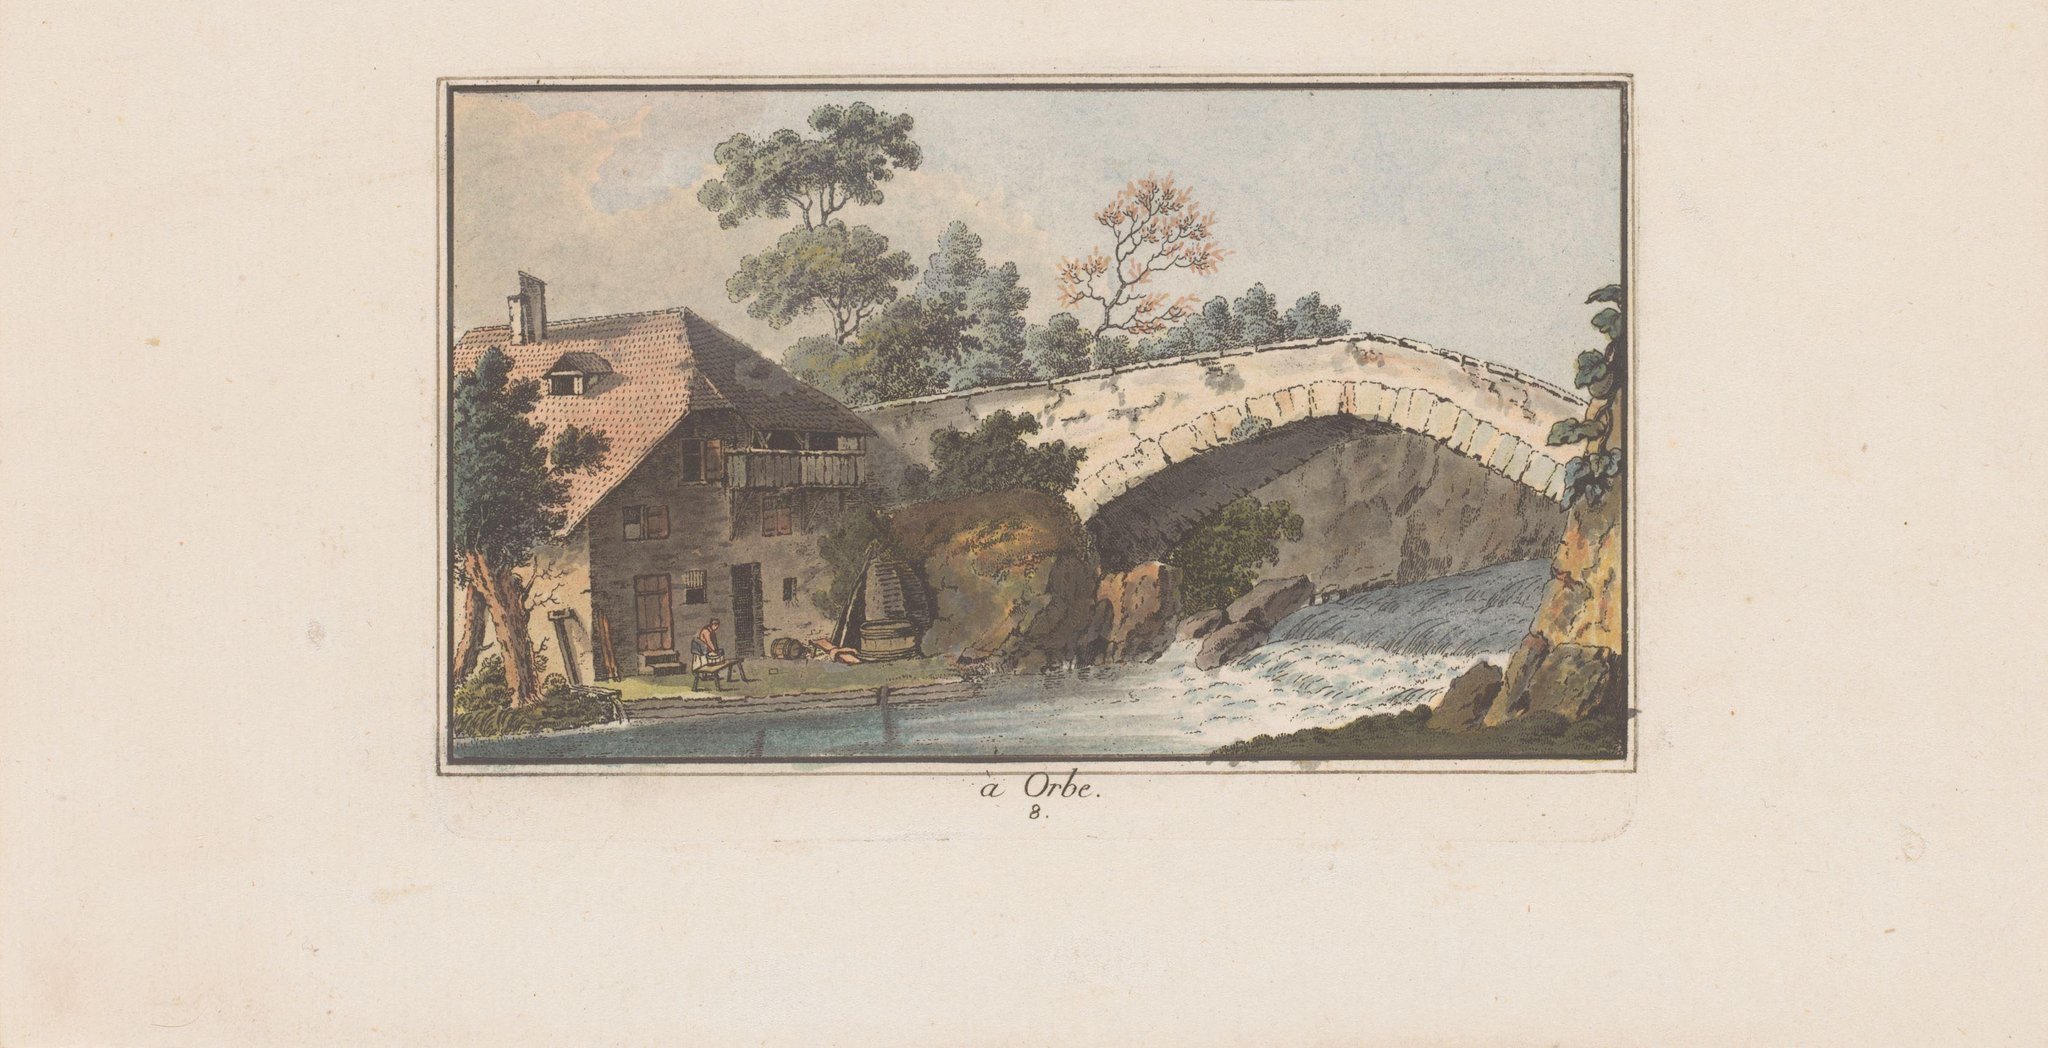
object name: print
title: à Orbe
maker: heinrich rieter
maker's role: print maker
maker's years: 1751-1818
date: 1782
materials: paper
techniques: etching, hand coloring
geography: bern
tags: river, bridge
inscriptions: collector's mark: Lugt 533b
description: De reeks is gebaseerd op een reis die beide kunstenaars samen maakten in 1782.